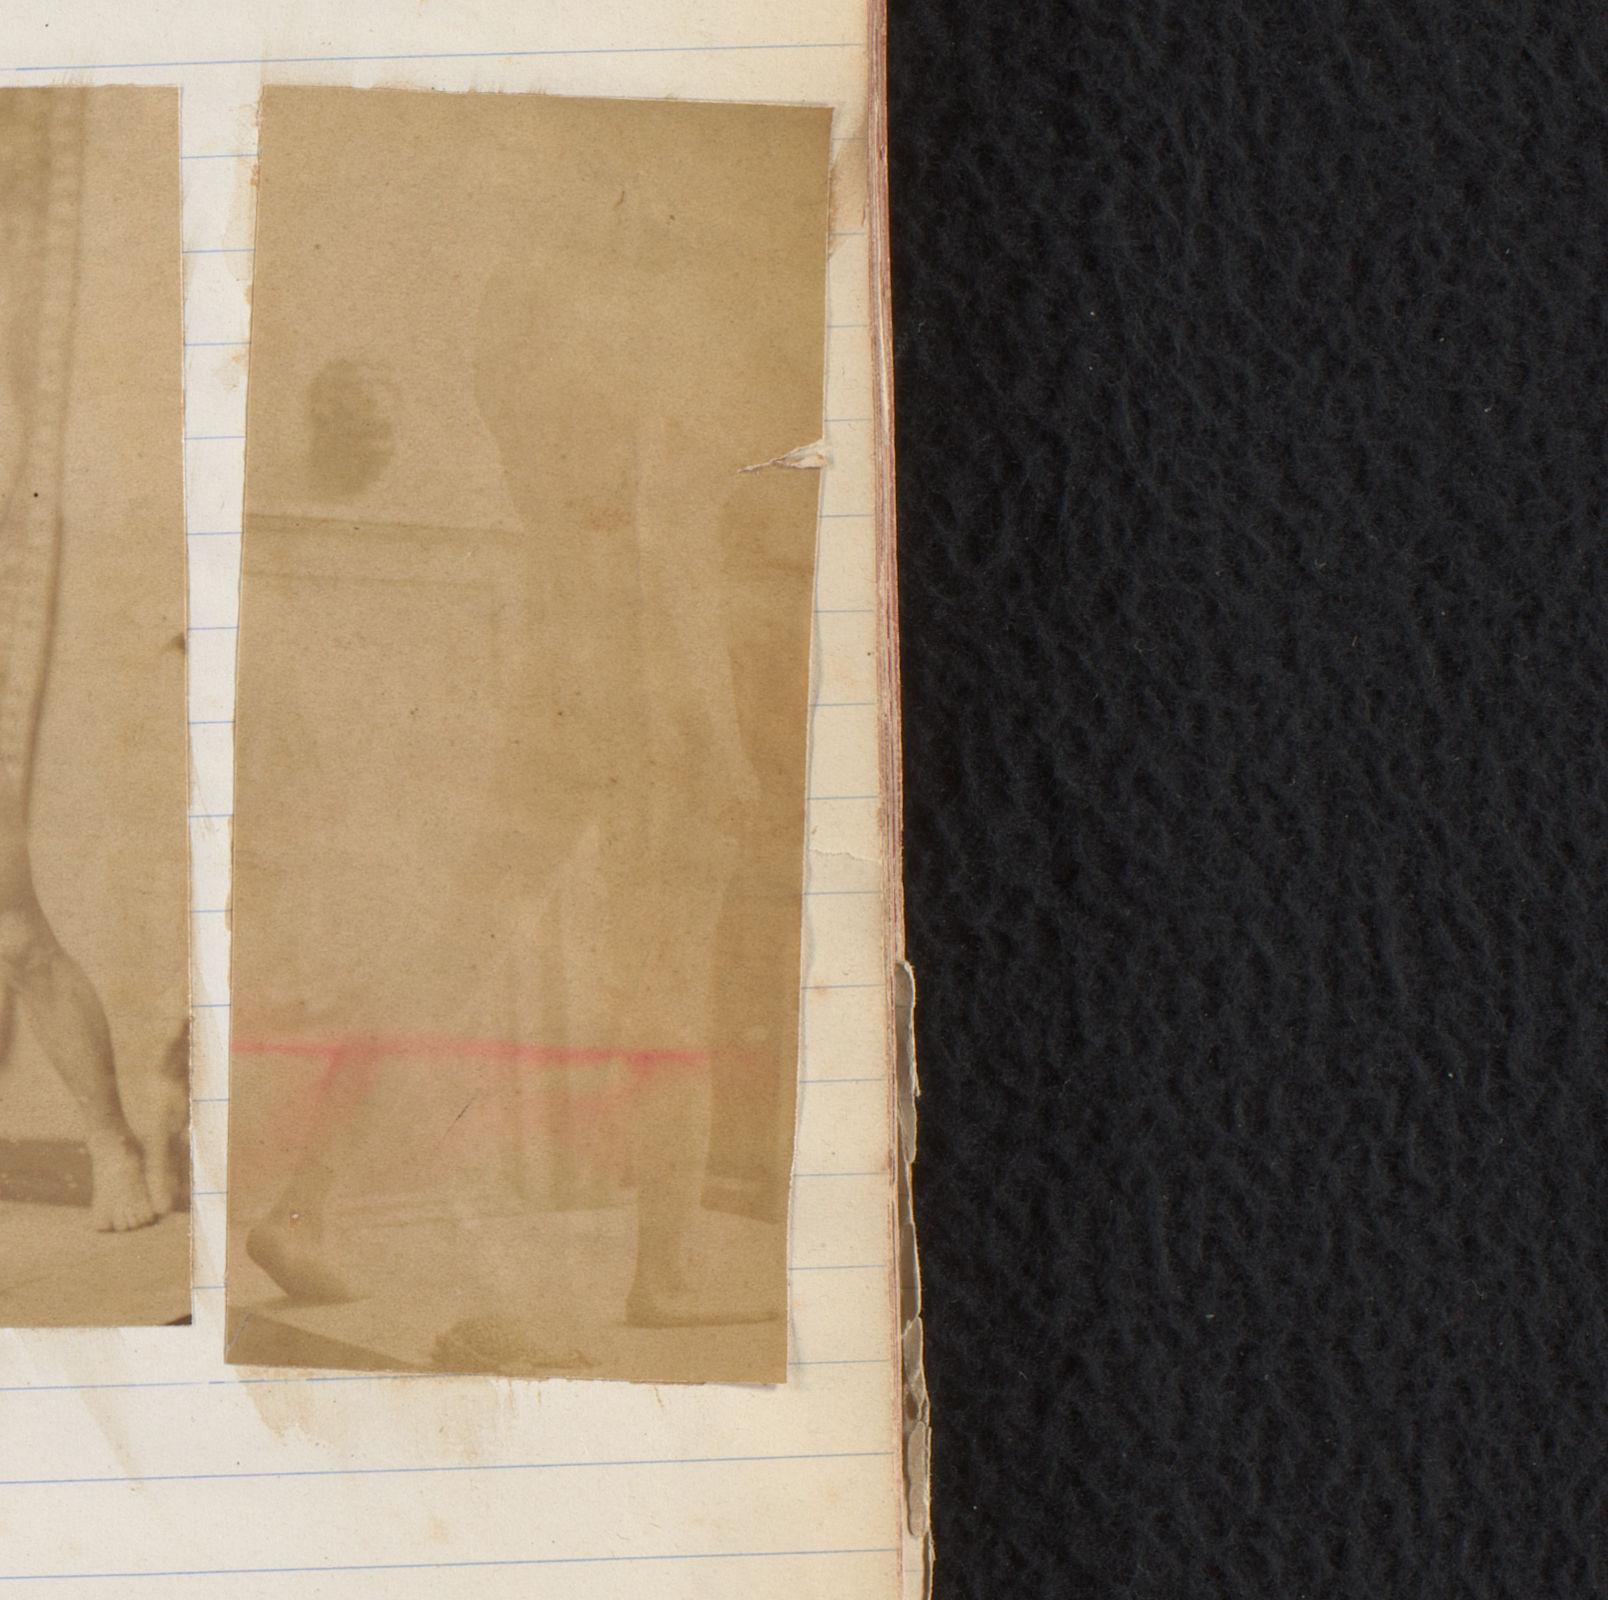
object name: album leaf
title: Studie van een mannelijk naaktmodel, rechtop staand en schuin van achter gezien, in het atelier van Jacques de Lalaing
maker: jacques lalaing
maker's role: painter, sculptor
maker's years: 1858-1917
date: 1883-1890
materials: photographic support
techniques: albumen print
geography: brussels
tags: adult man, artist (in general) working from nude model, the (nude) human figure; 'corpo humano' (ripa) (+ standing)